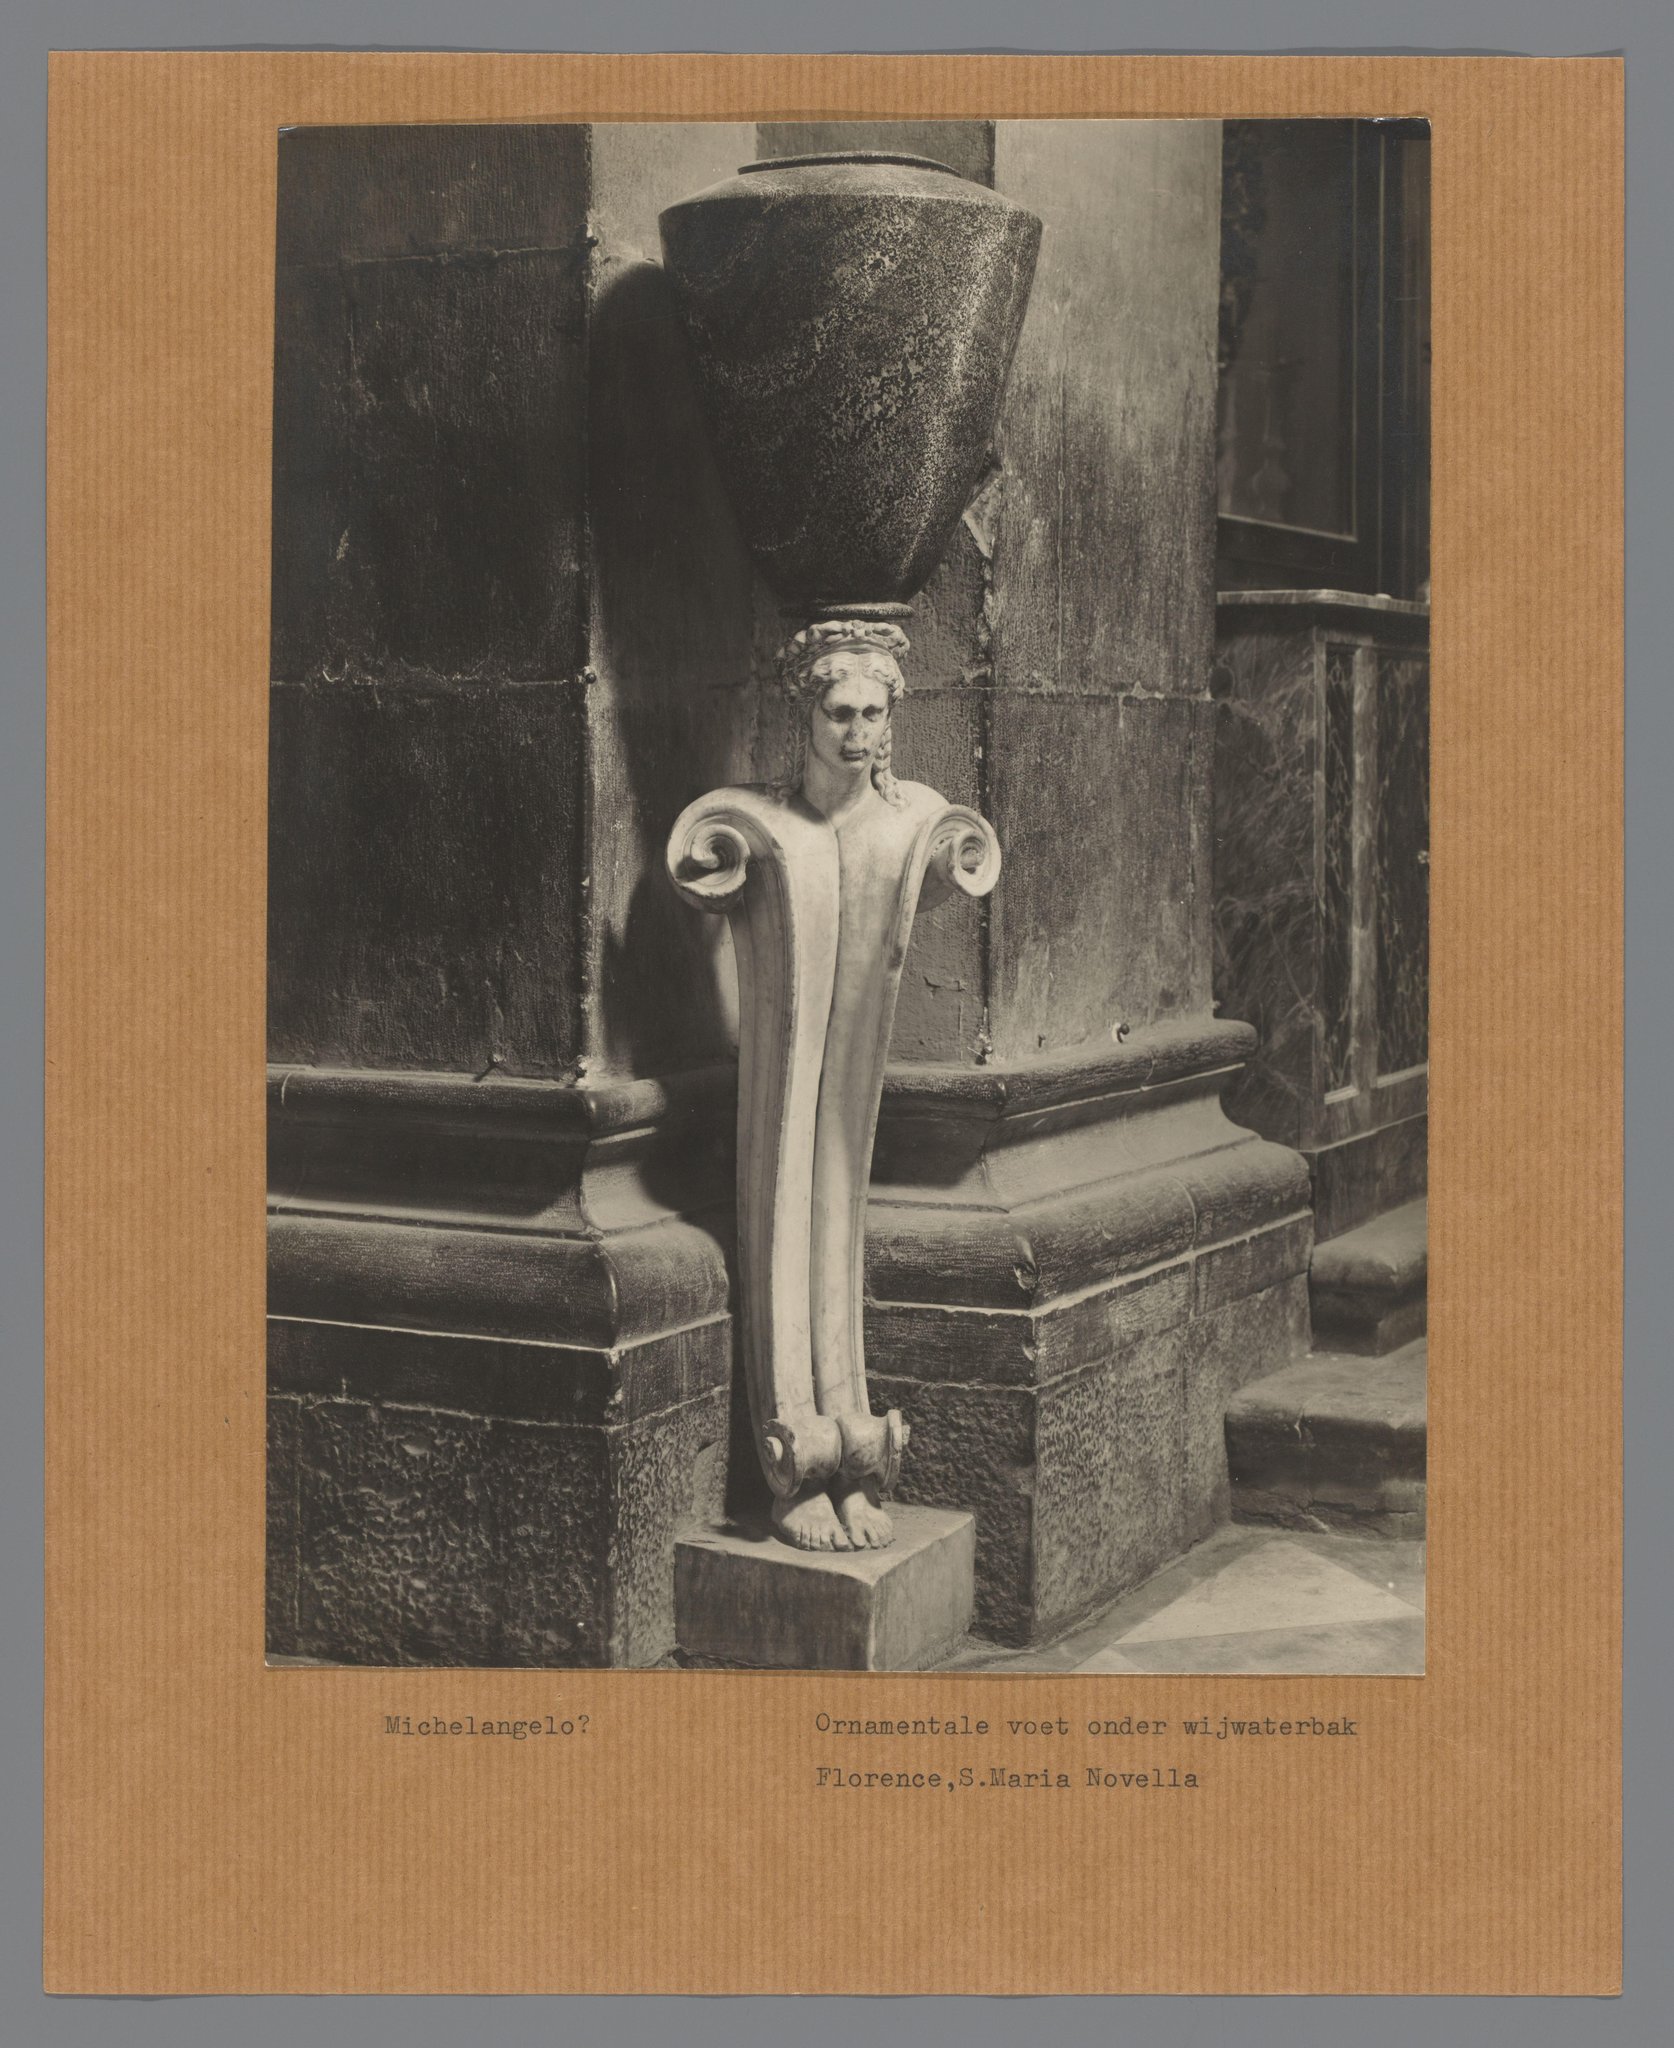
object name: photograph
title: Italië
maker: Anonymous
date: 1880-1910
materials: photographic support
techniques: albumen print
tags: italy